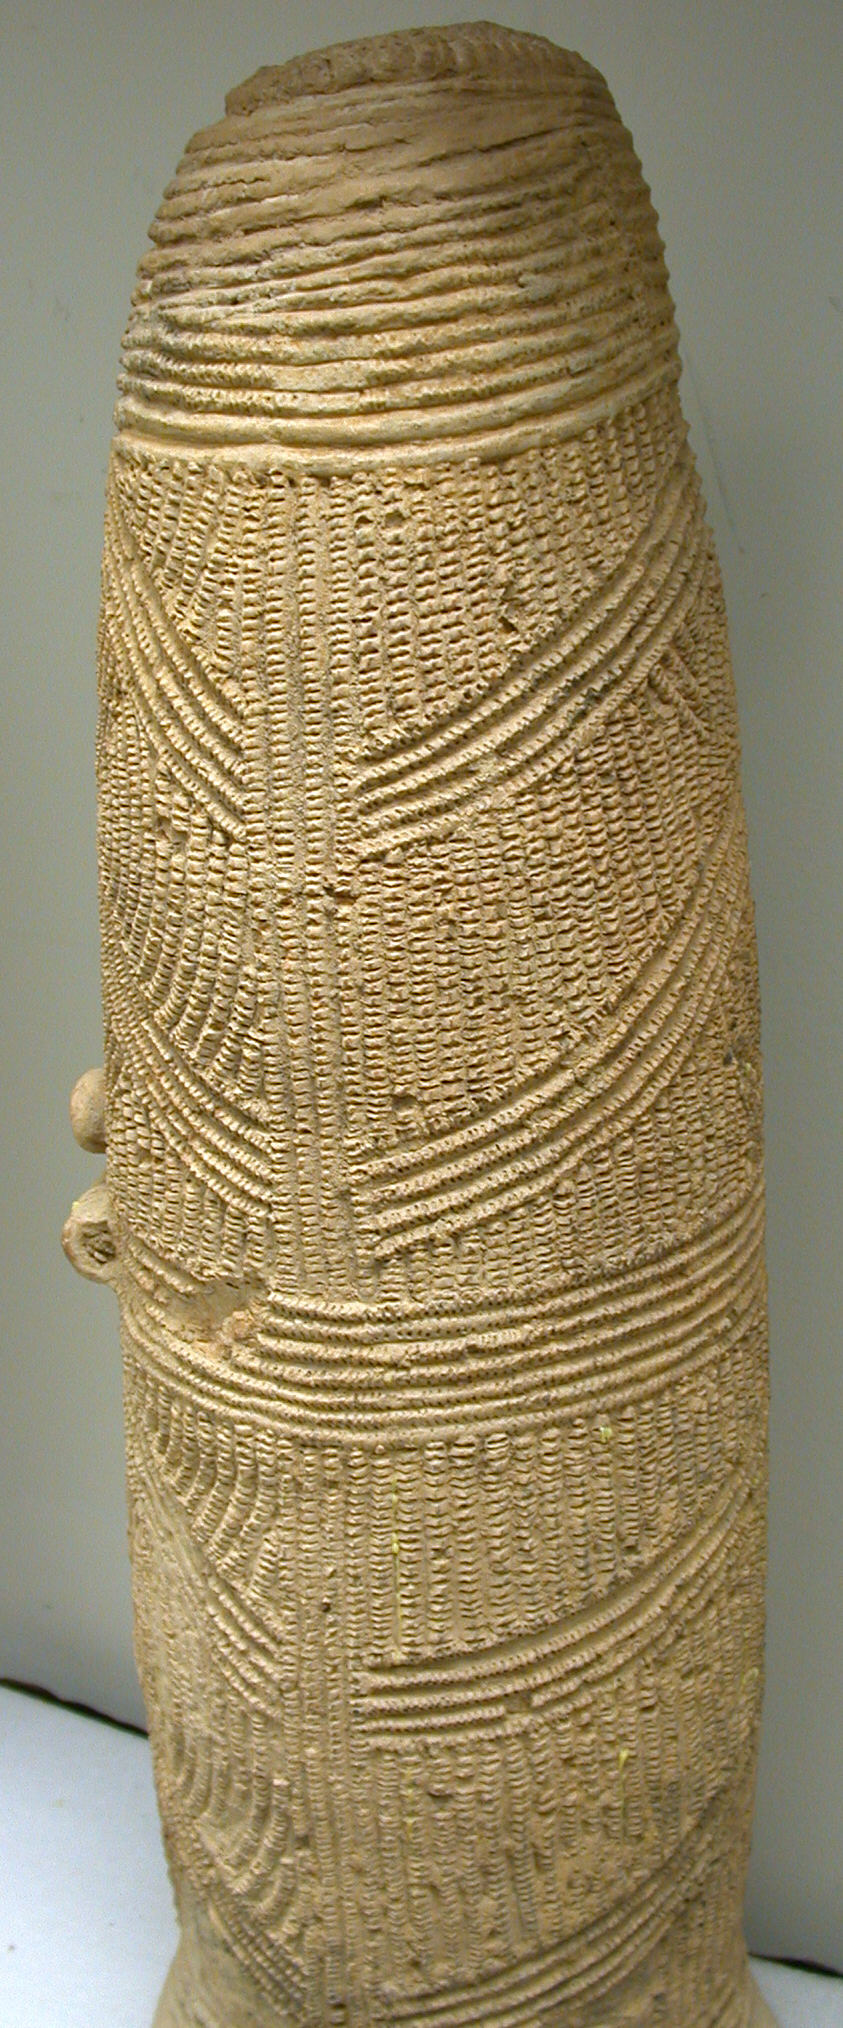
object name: grave marker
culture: bura peoples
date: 201-1100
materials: terracotta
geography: niger